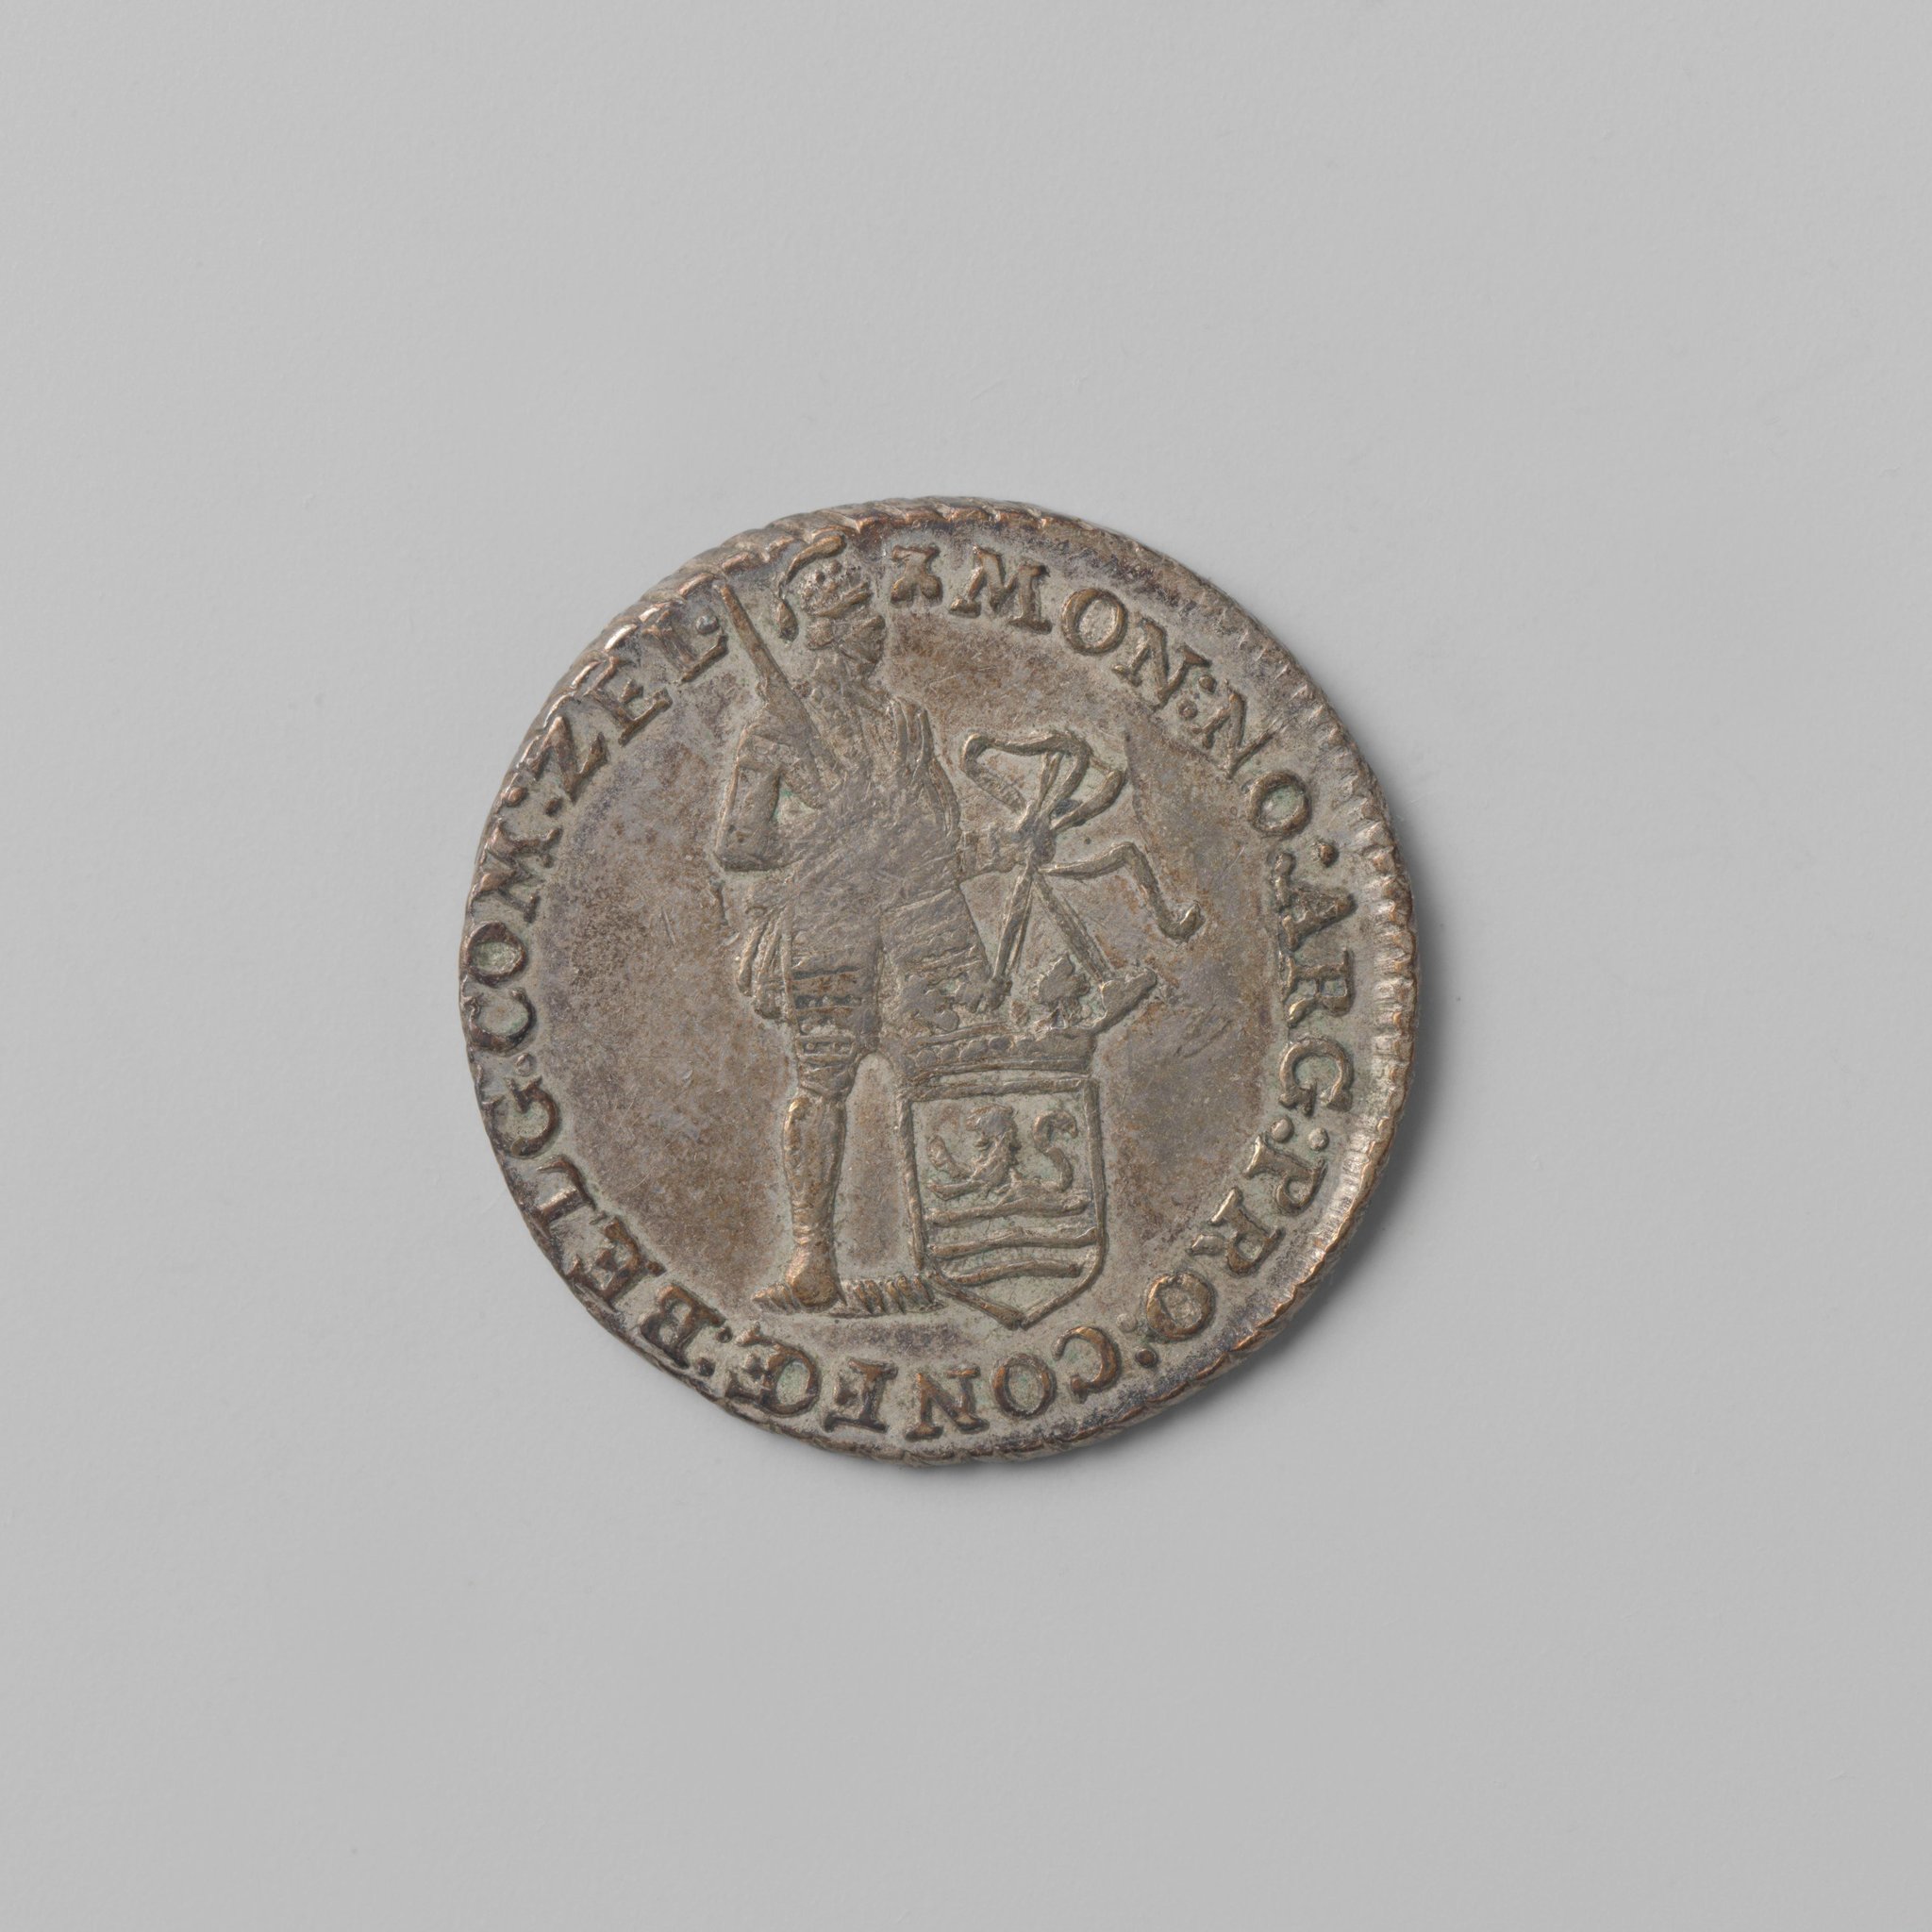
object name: zilveren dukaat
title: Zeeuwse kwart zilveren dukaat, 1791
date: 1791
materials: silver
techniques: striking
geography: middelburg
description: Zilveren munt. Voorzijde: staande geharnaste ridder naar rechts met zwaard in rechterhand en gekroond wapenschild van Zeeland aan lint in linkerhand. Keerzijde: versierd gekroond generaliteitswapenschild. Boven kroon jaartal. Kabelrand.